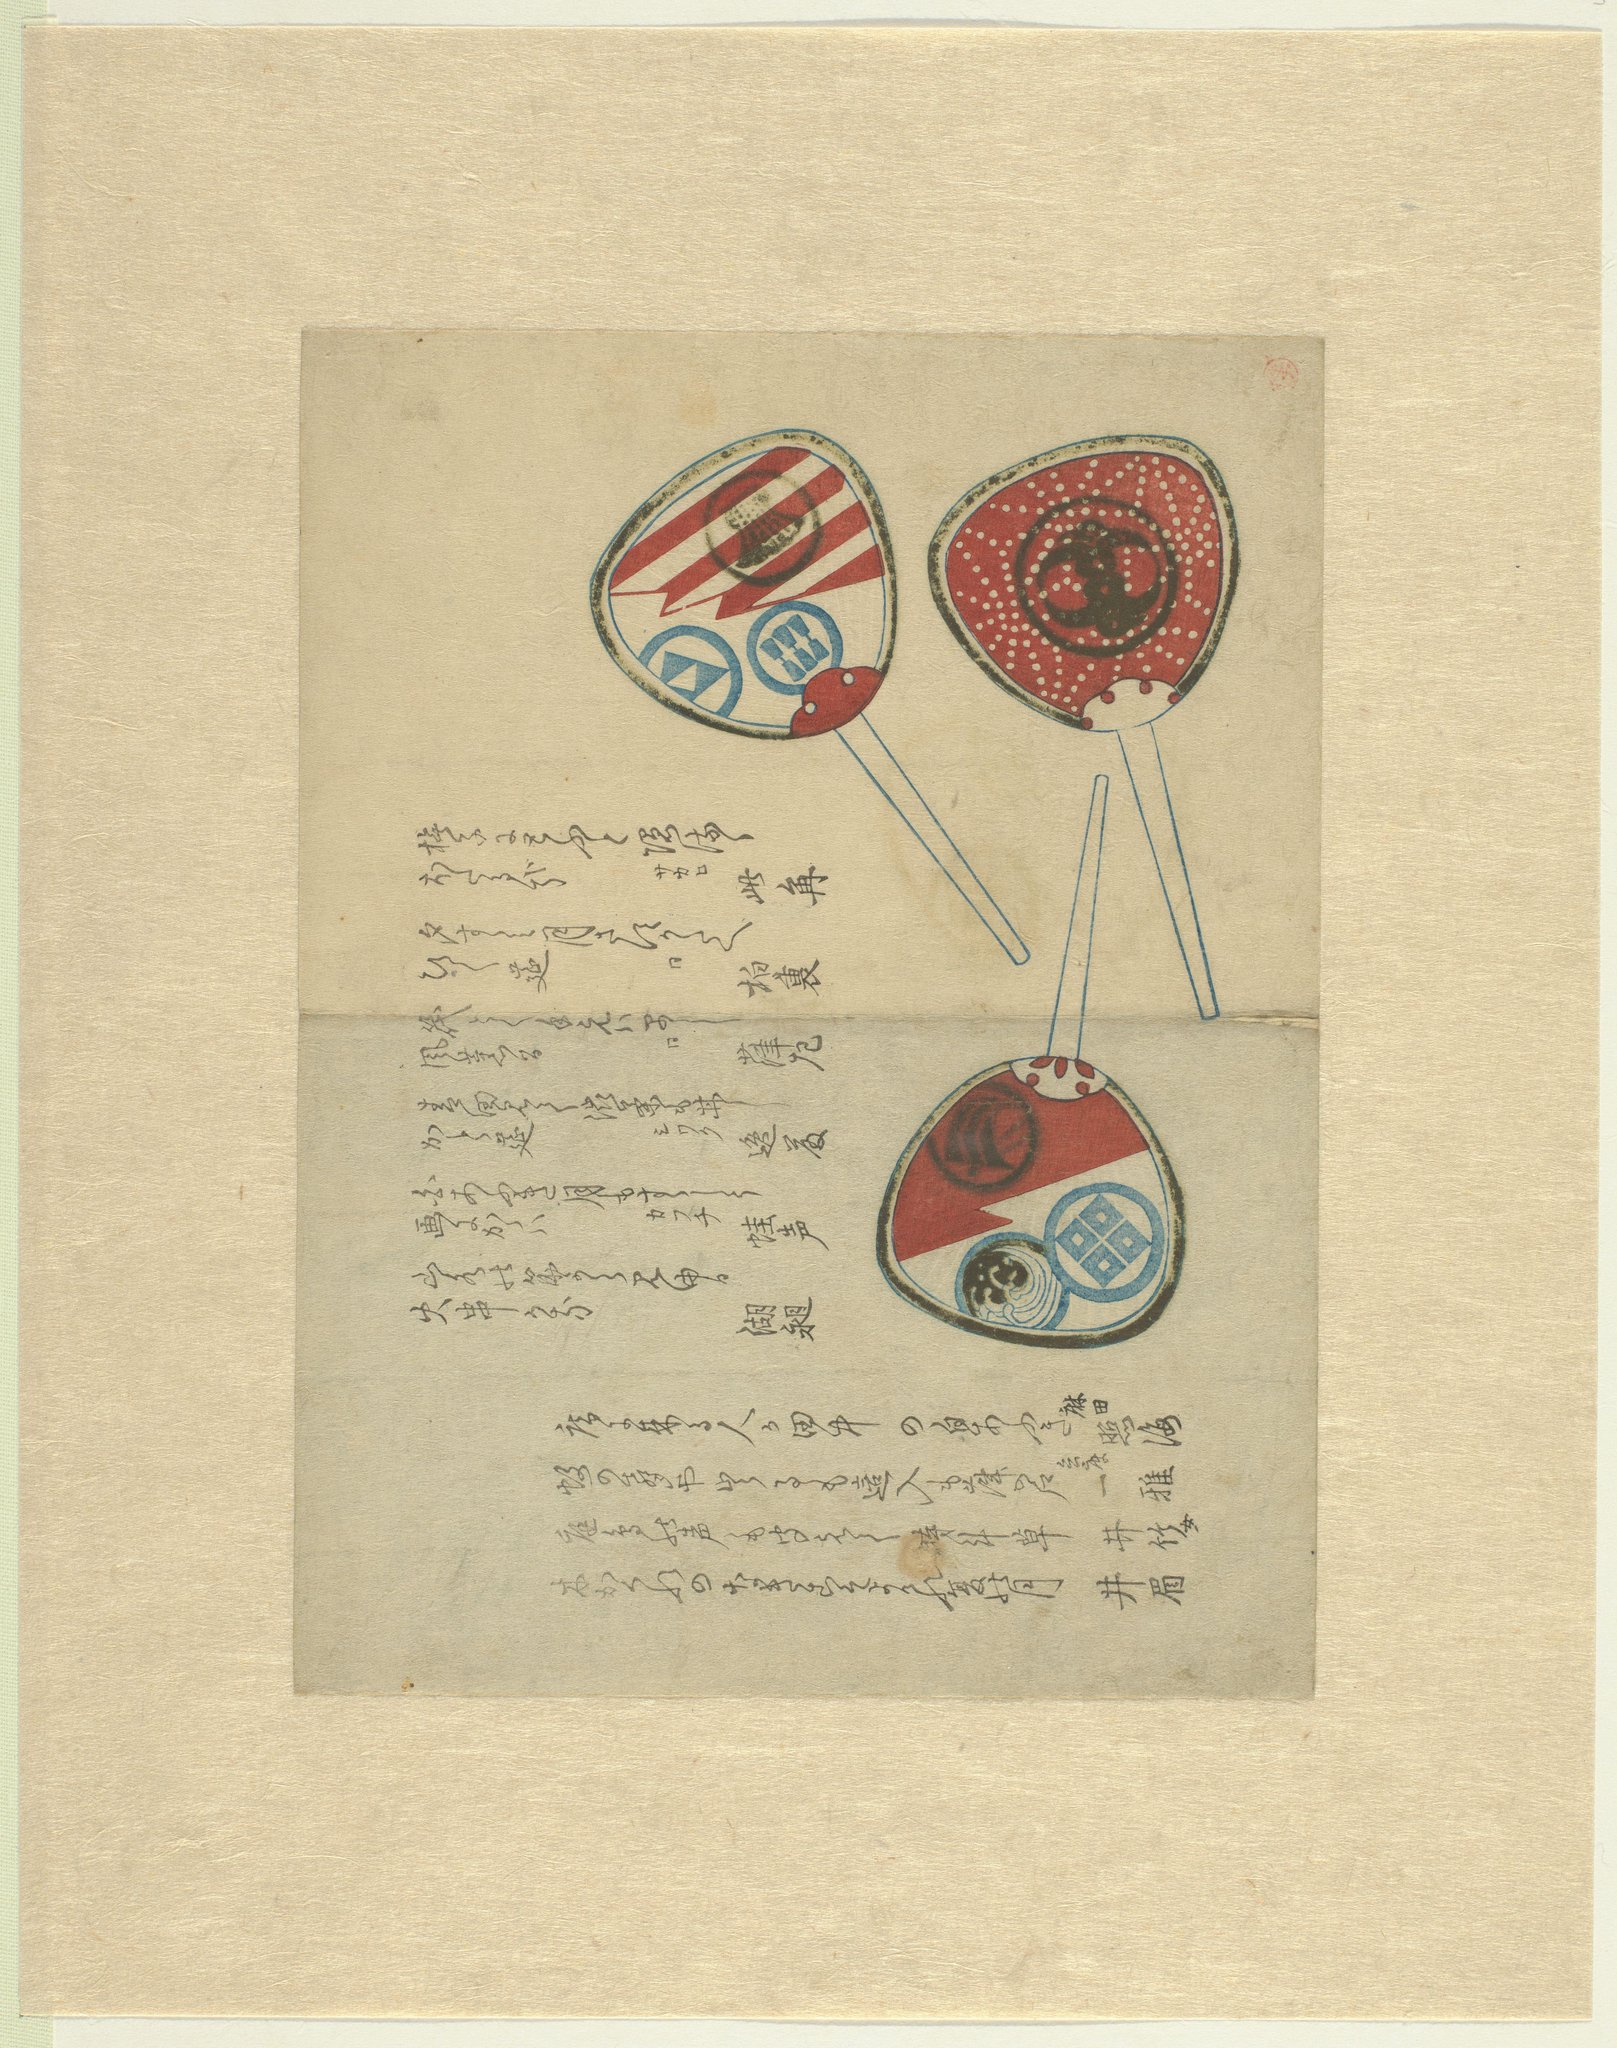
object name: surimono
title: Drie waaiers met familiewapens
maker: Anonymous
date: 1820-1830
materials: paper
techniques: woodcut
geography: japan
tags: fan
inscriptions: inscription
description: Een surimono is een luxe uitgevoerde prent waarop beeld met één of meerdere gedichten gecombineerd is. Bij het drukken van een surimono werd vaak gebruik gemaakt van dikker papier, blinddruk en metaal pigmenten, zoals koper- en zilverpoeder. De prenten werden vaak in opdracht van dichters gemaakt en als exclusief geschenk aan vrienden en relaties gegeven.